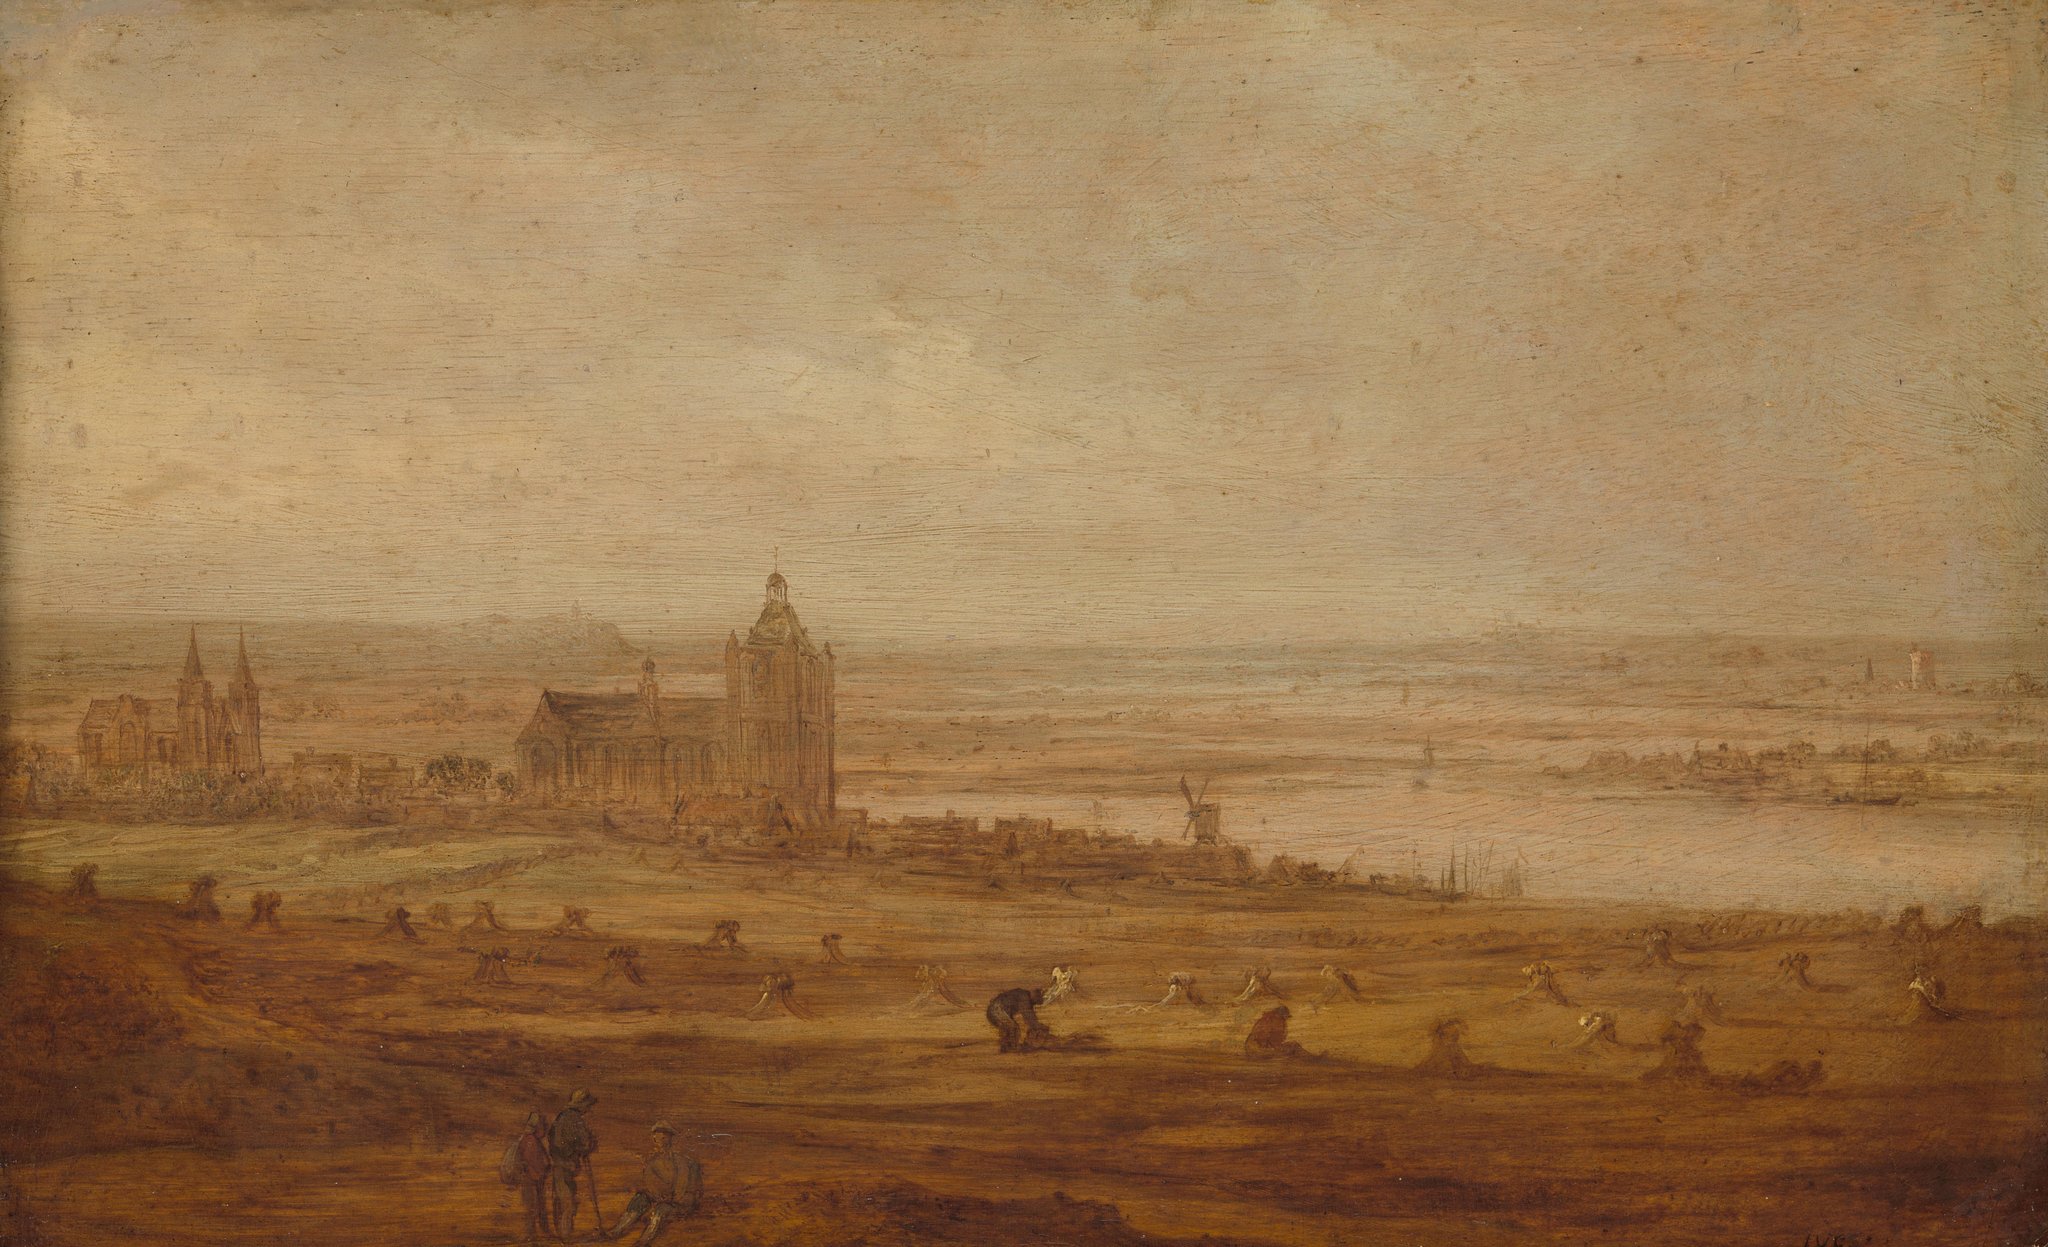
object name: painting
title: View of Arnhem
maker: jan van goyen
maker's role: draughtsman, painter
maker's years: 1596-1656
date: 1644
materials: oil, panel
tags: harvest, city-view, and landscape with man-made constructions (+ city(-scape) with figures, staffage), arnhem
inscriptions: signature, with monogram, bottom right (falsely): ‘IVG’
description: Gezicht over glooiende korenvelden met korenschoven op de stad Arnhem, rechts de Rijn.